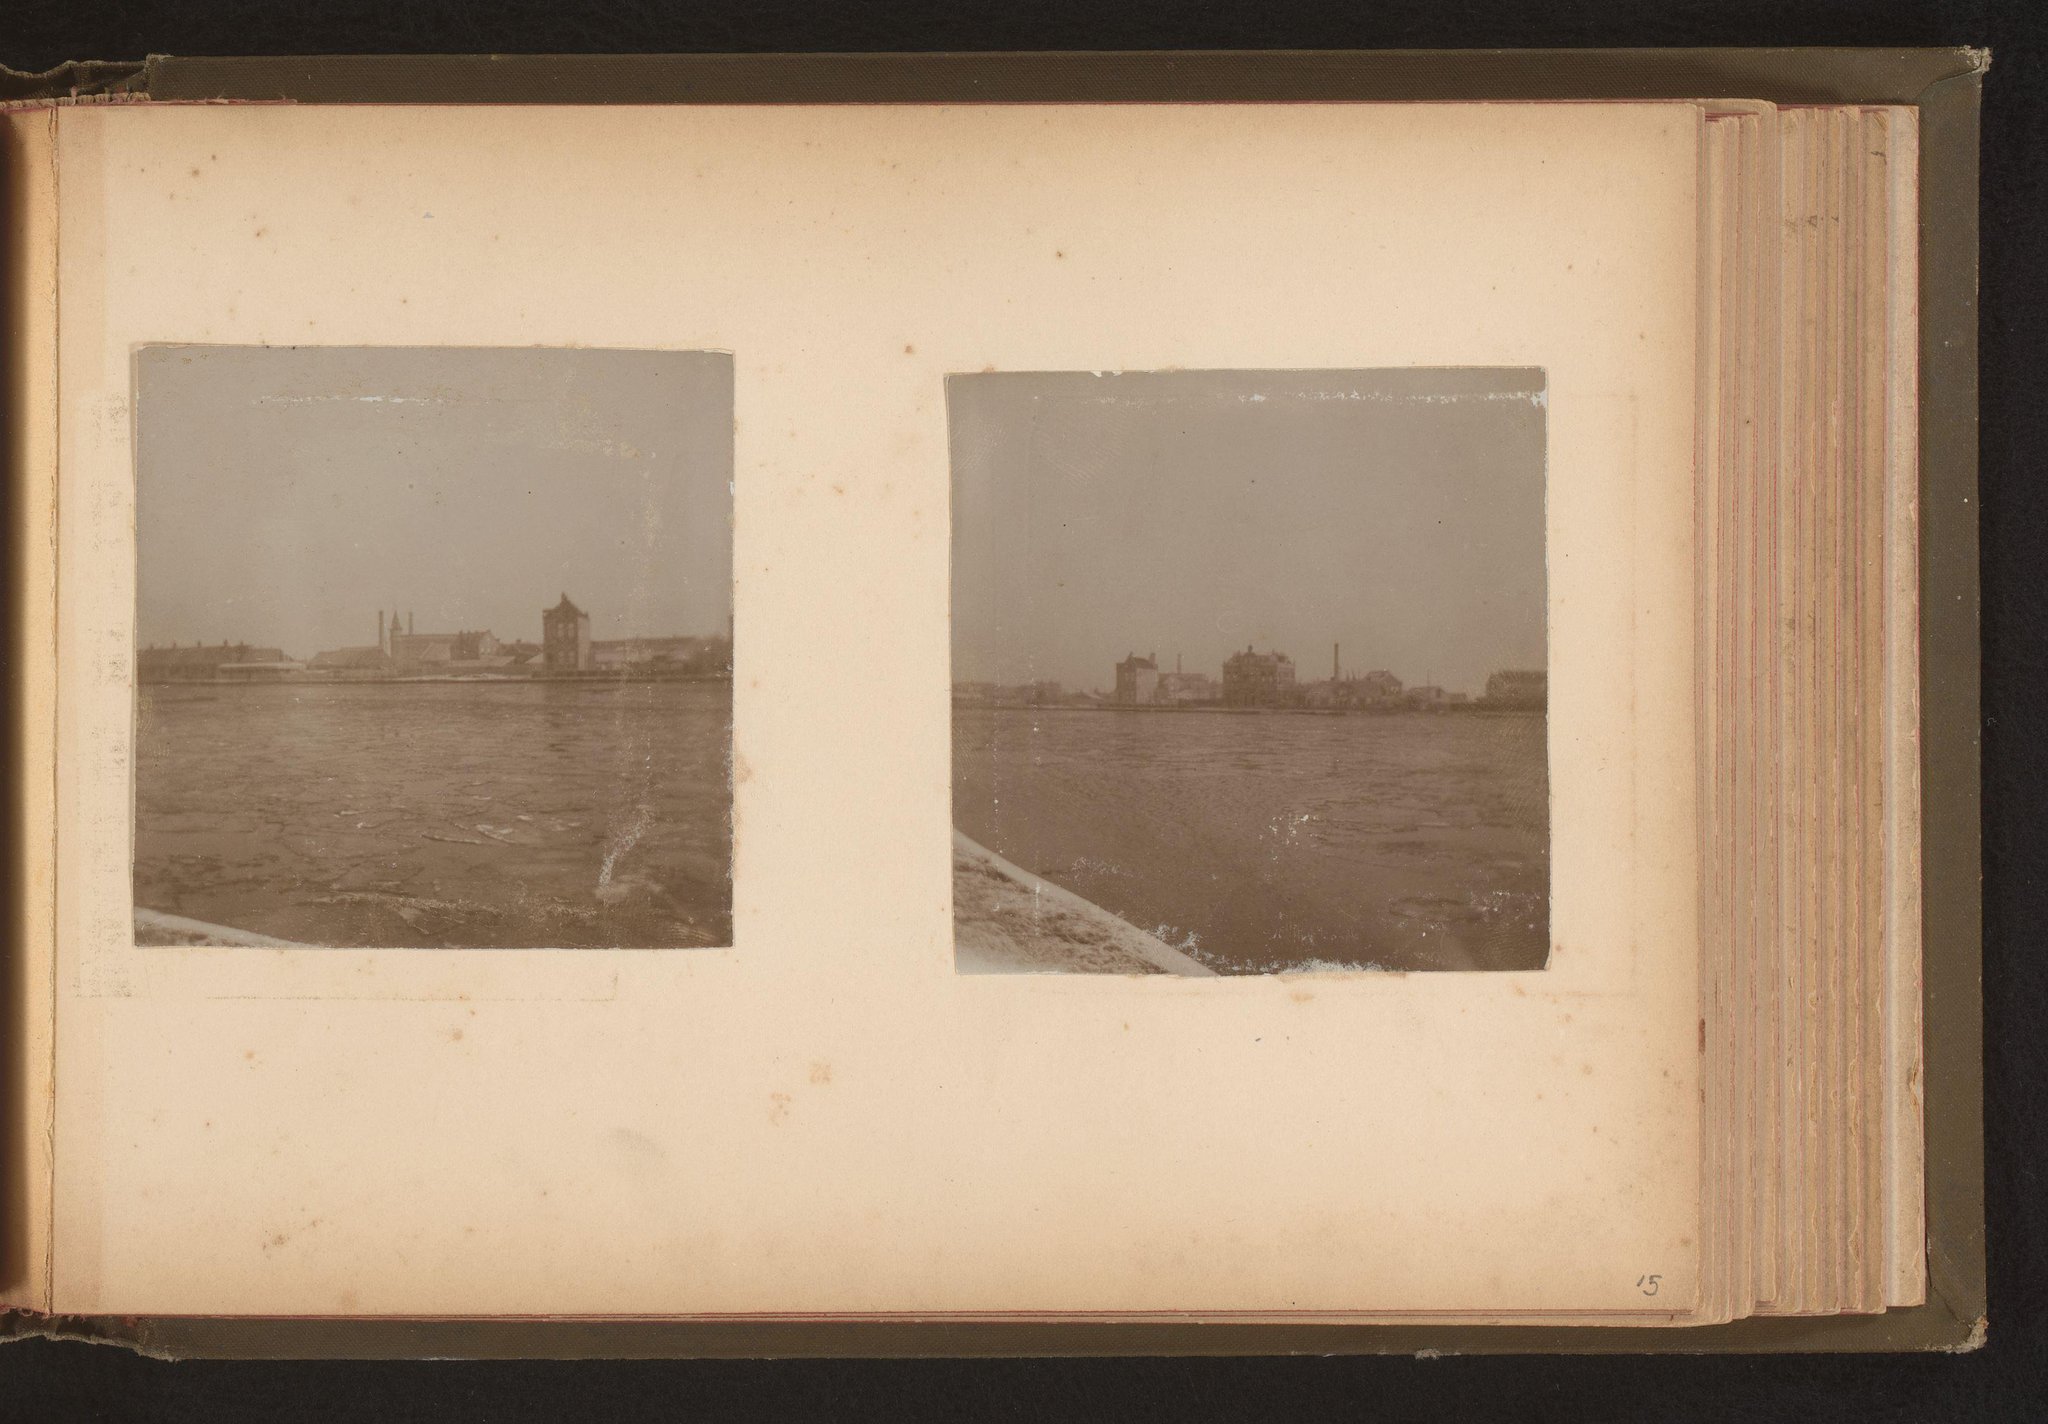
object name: album leaf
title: Twee foto's van huizen en fabrieken aan een rivier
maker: Anonymous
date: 1895-1910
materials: paper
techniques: collodion silver print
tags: river, factory in landscape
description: Deze foto's maken deel uit van een album.